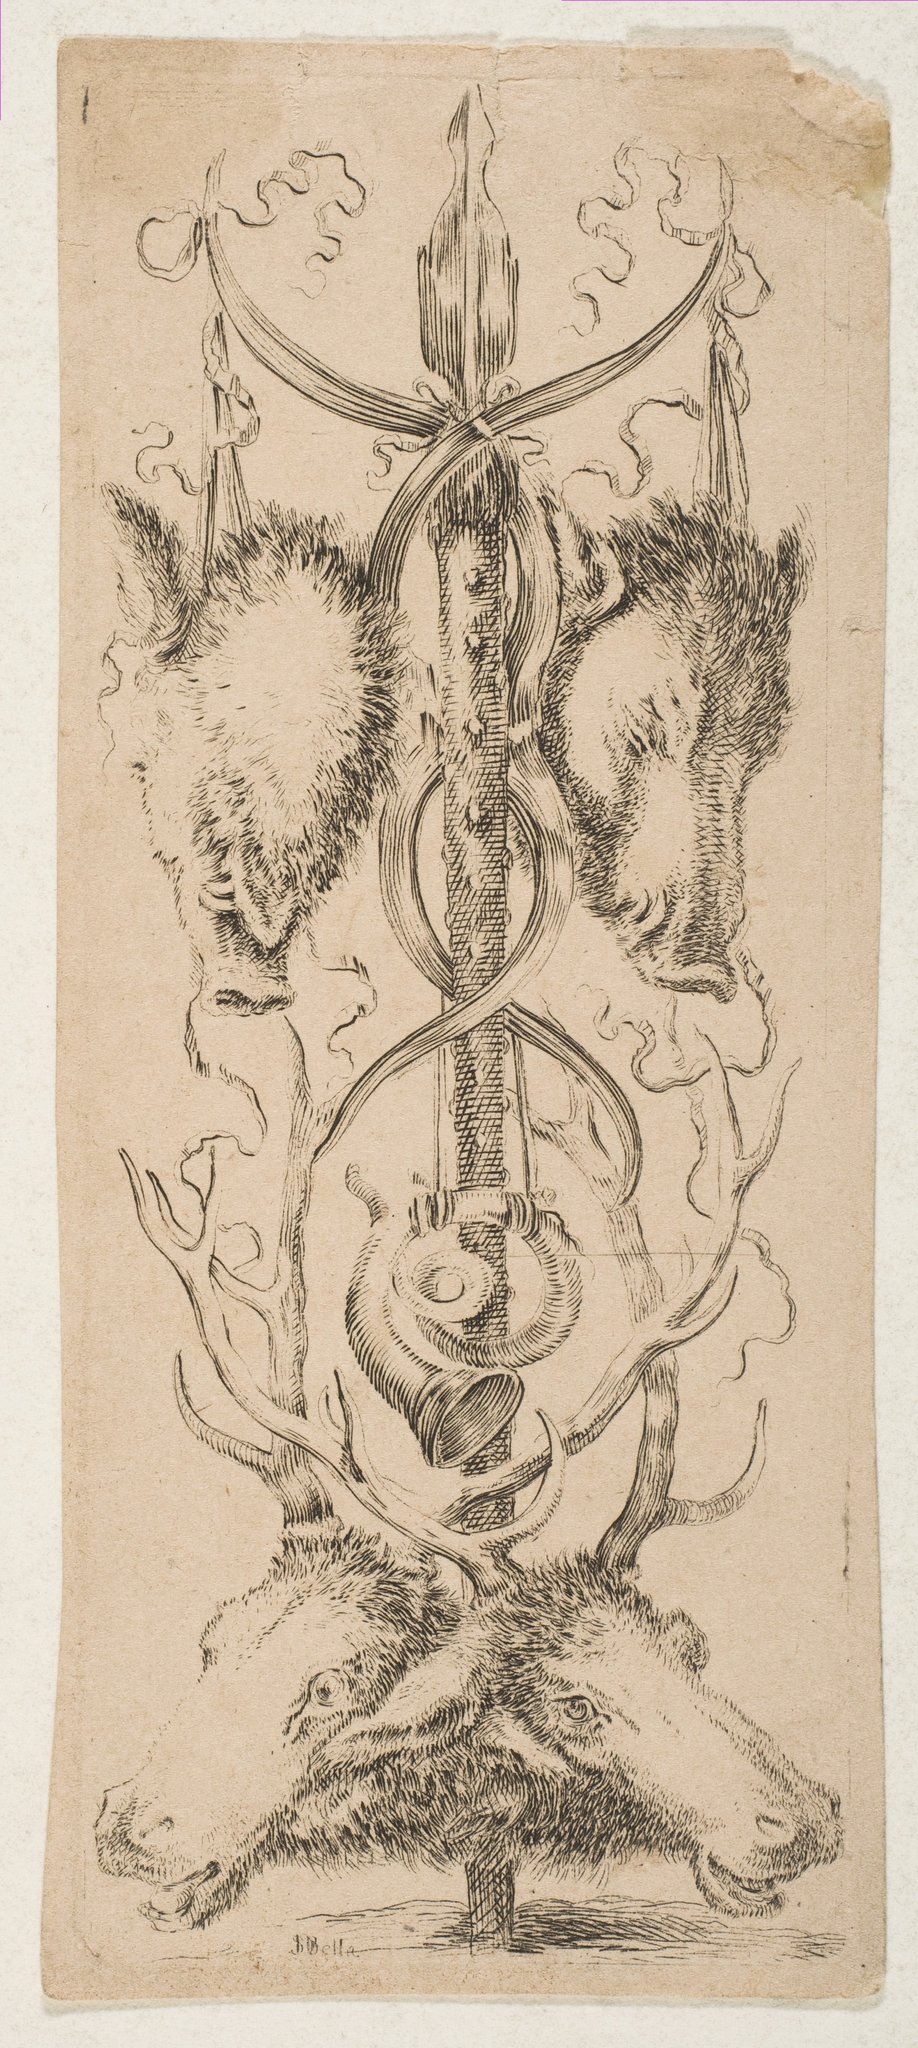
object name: print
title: Hunting Trophy with Stag Heads Below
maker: stefano della bella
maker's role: artist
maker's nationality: italian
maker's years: 1610-1664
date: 1653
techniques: etching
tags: deer,pigs